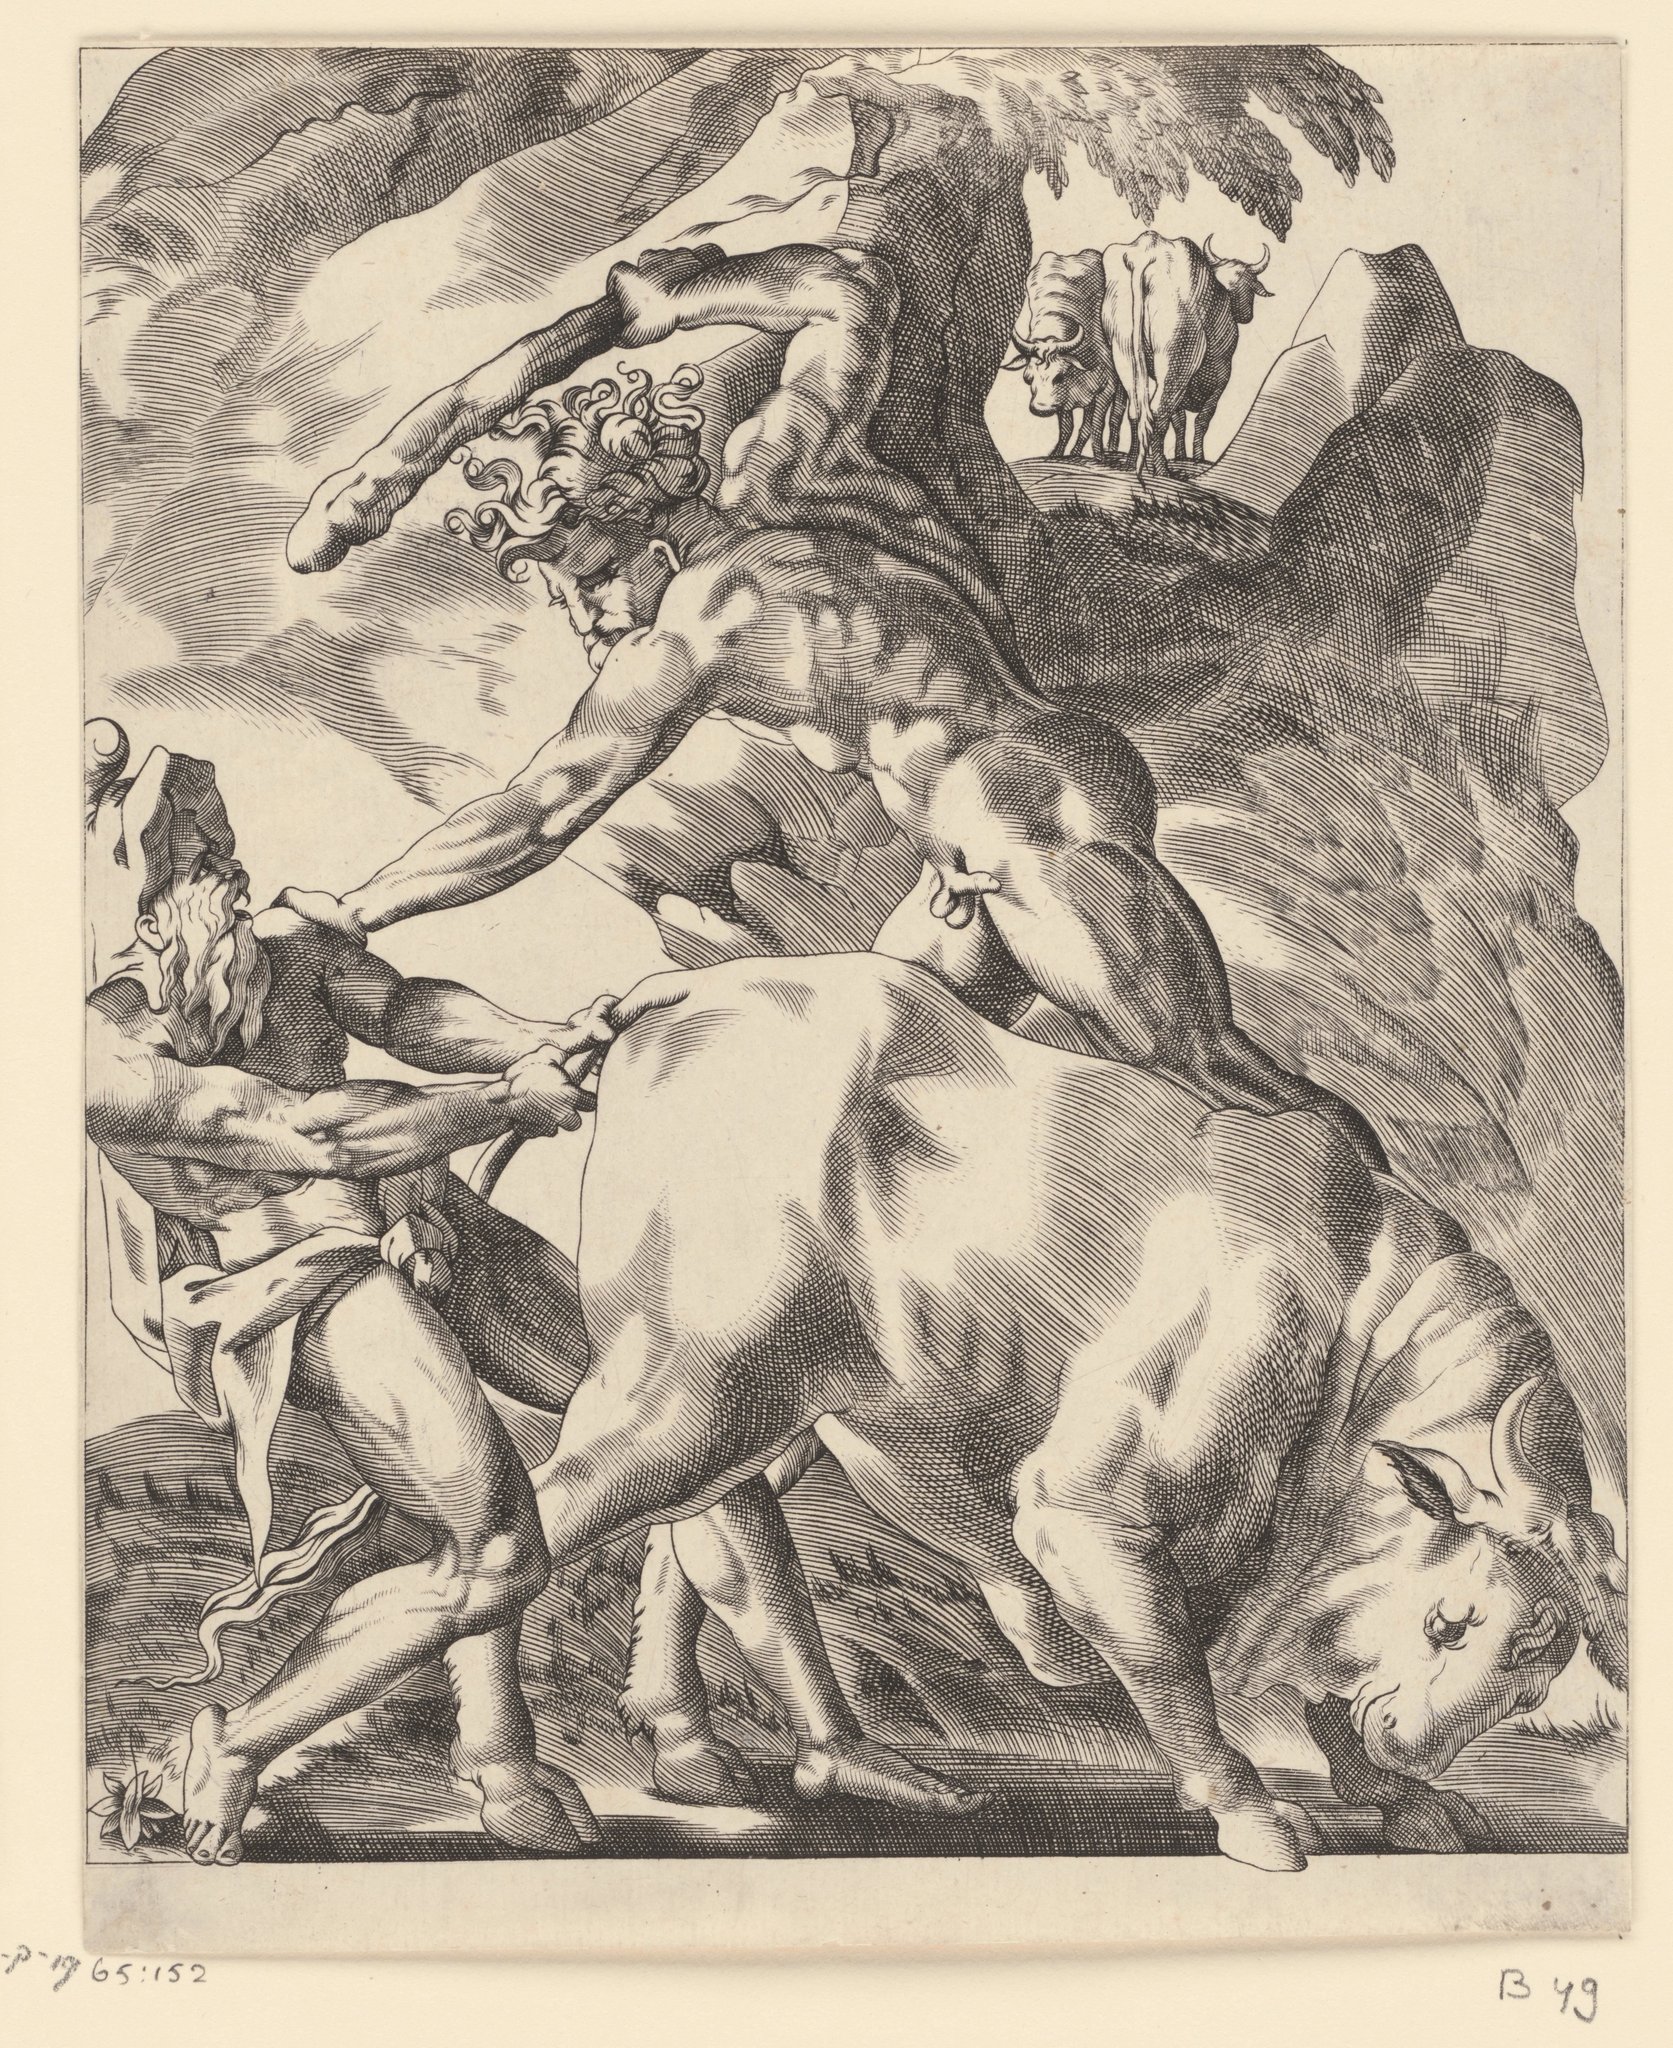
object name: print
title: Hercules vecht met Cacus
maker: giovanni jacopo caraglio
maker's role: goldsmith, print maker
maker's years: 1500-1565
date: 1515-1565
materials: paper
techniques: engraving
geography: italy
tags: cacus, the fire-breathing monster is killed in his cave by hercules, cacus steals some of the cattle of geryon which hercules was driving home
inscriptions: collector's mark: Lugt 2760, collector's mark: Lugt 3761, collector's mark: Lugt 567, collector's mark: Lugt 2228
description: Hercules staat met geheven knots op het punt Cacus aan te vallen omdat hij de runderen van Geryon probeert te stelen. Cacus trekt aan de staart van een van de runderen.